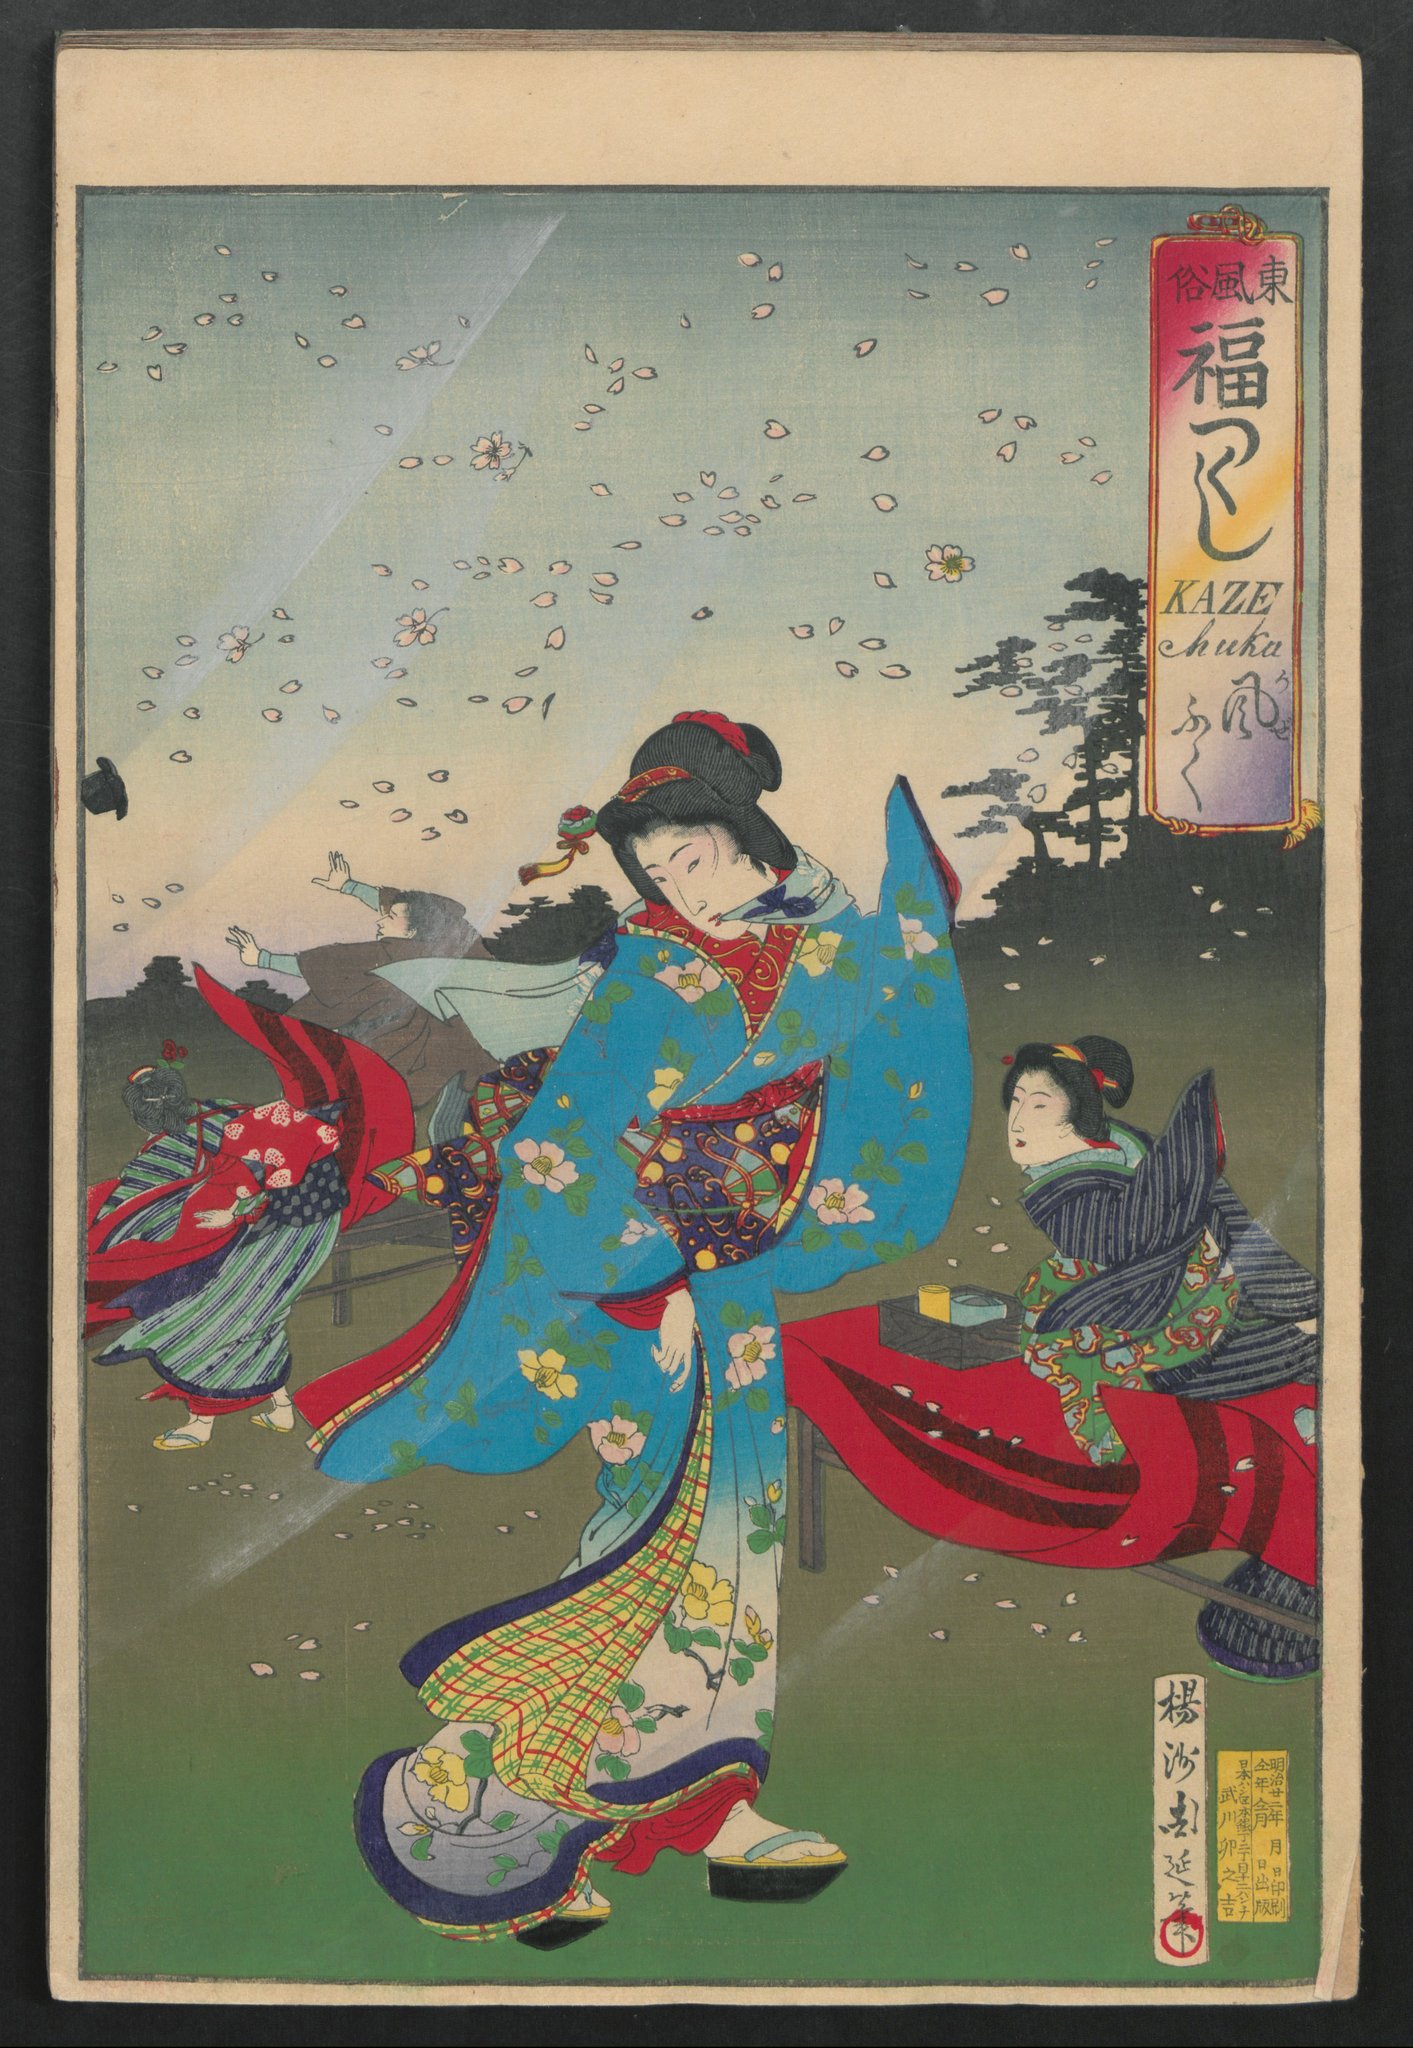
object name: print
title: Twenty-six Prints Constituting an Album (Azuma fūzoku fuku tsukushi) 東風俗 福つくし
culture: japanese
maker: yōshū chikanobu 楊洲周延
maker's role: artist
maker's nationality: japanese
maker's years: 1838-1912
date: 1867-1900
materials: ink, paper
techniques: woodblock print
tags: interiors,children,men,women,wind